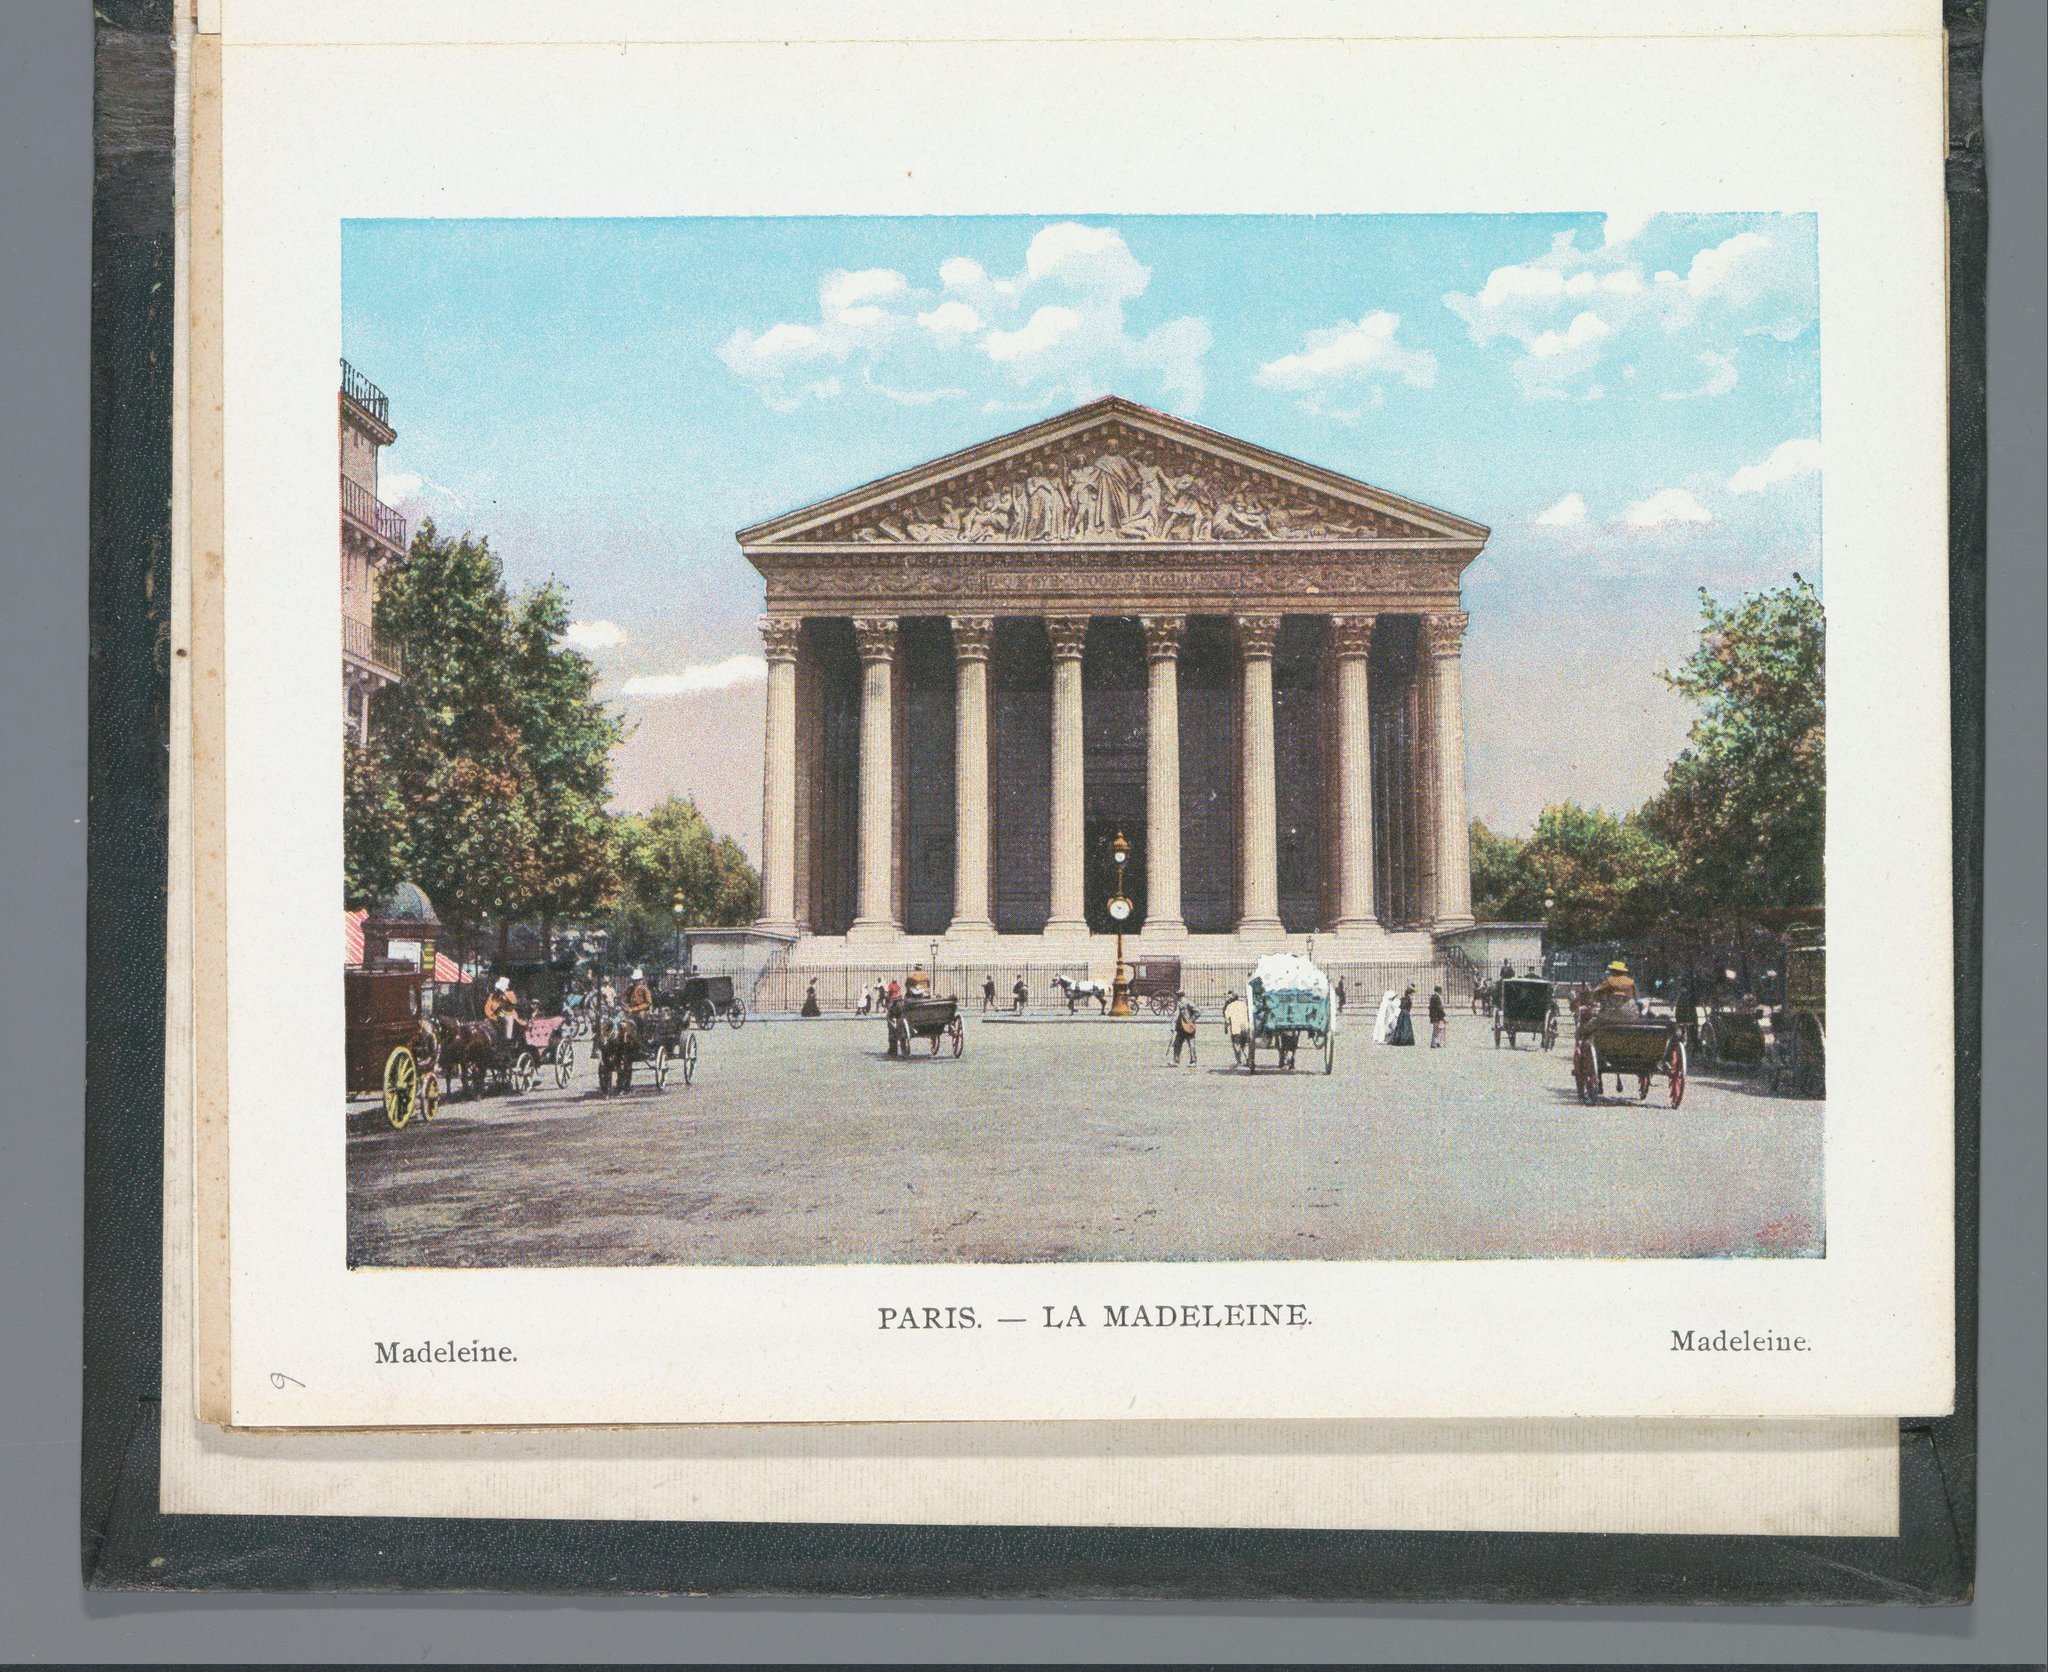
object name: photograph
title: Paris. - La Madeleine.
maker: Anonymous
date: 1900-1930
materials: cardboard, paper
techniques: autotype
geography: paris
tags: animal traction, animal-drawn vehicle (carriage etc.), church (exterior), travelling; tourism, prospect of city, town panorama, silhouette of city, street (+ city(-scape) with figures, staffage), paris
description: Onderdeel van Fotoalbum met kleurenopnames van bezienswaardigheden in Parijs.